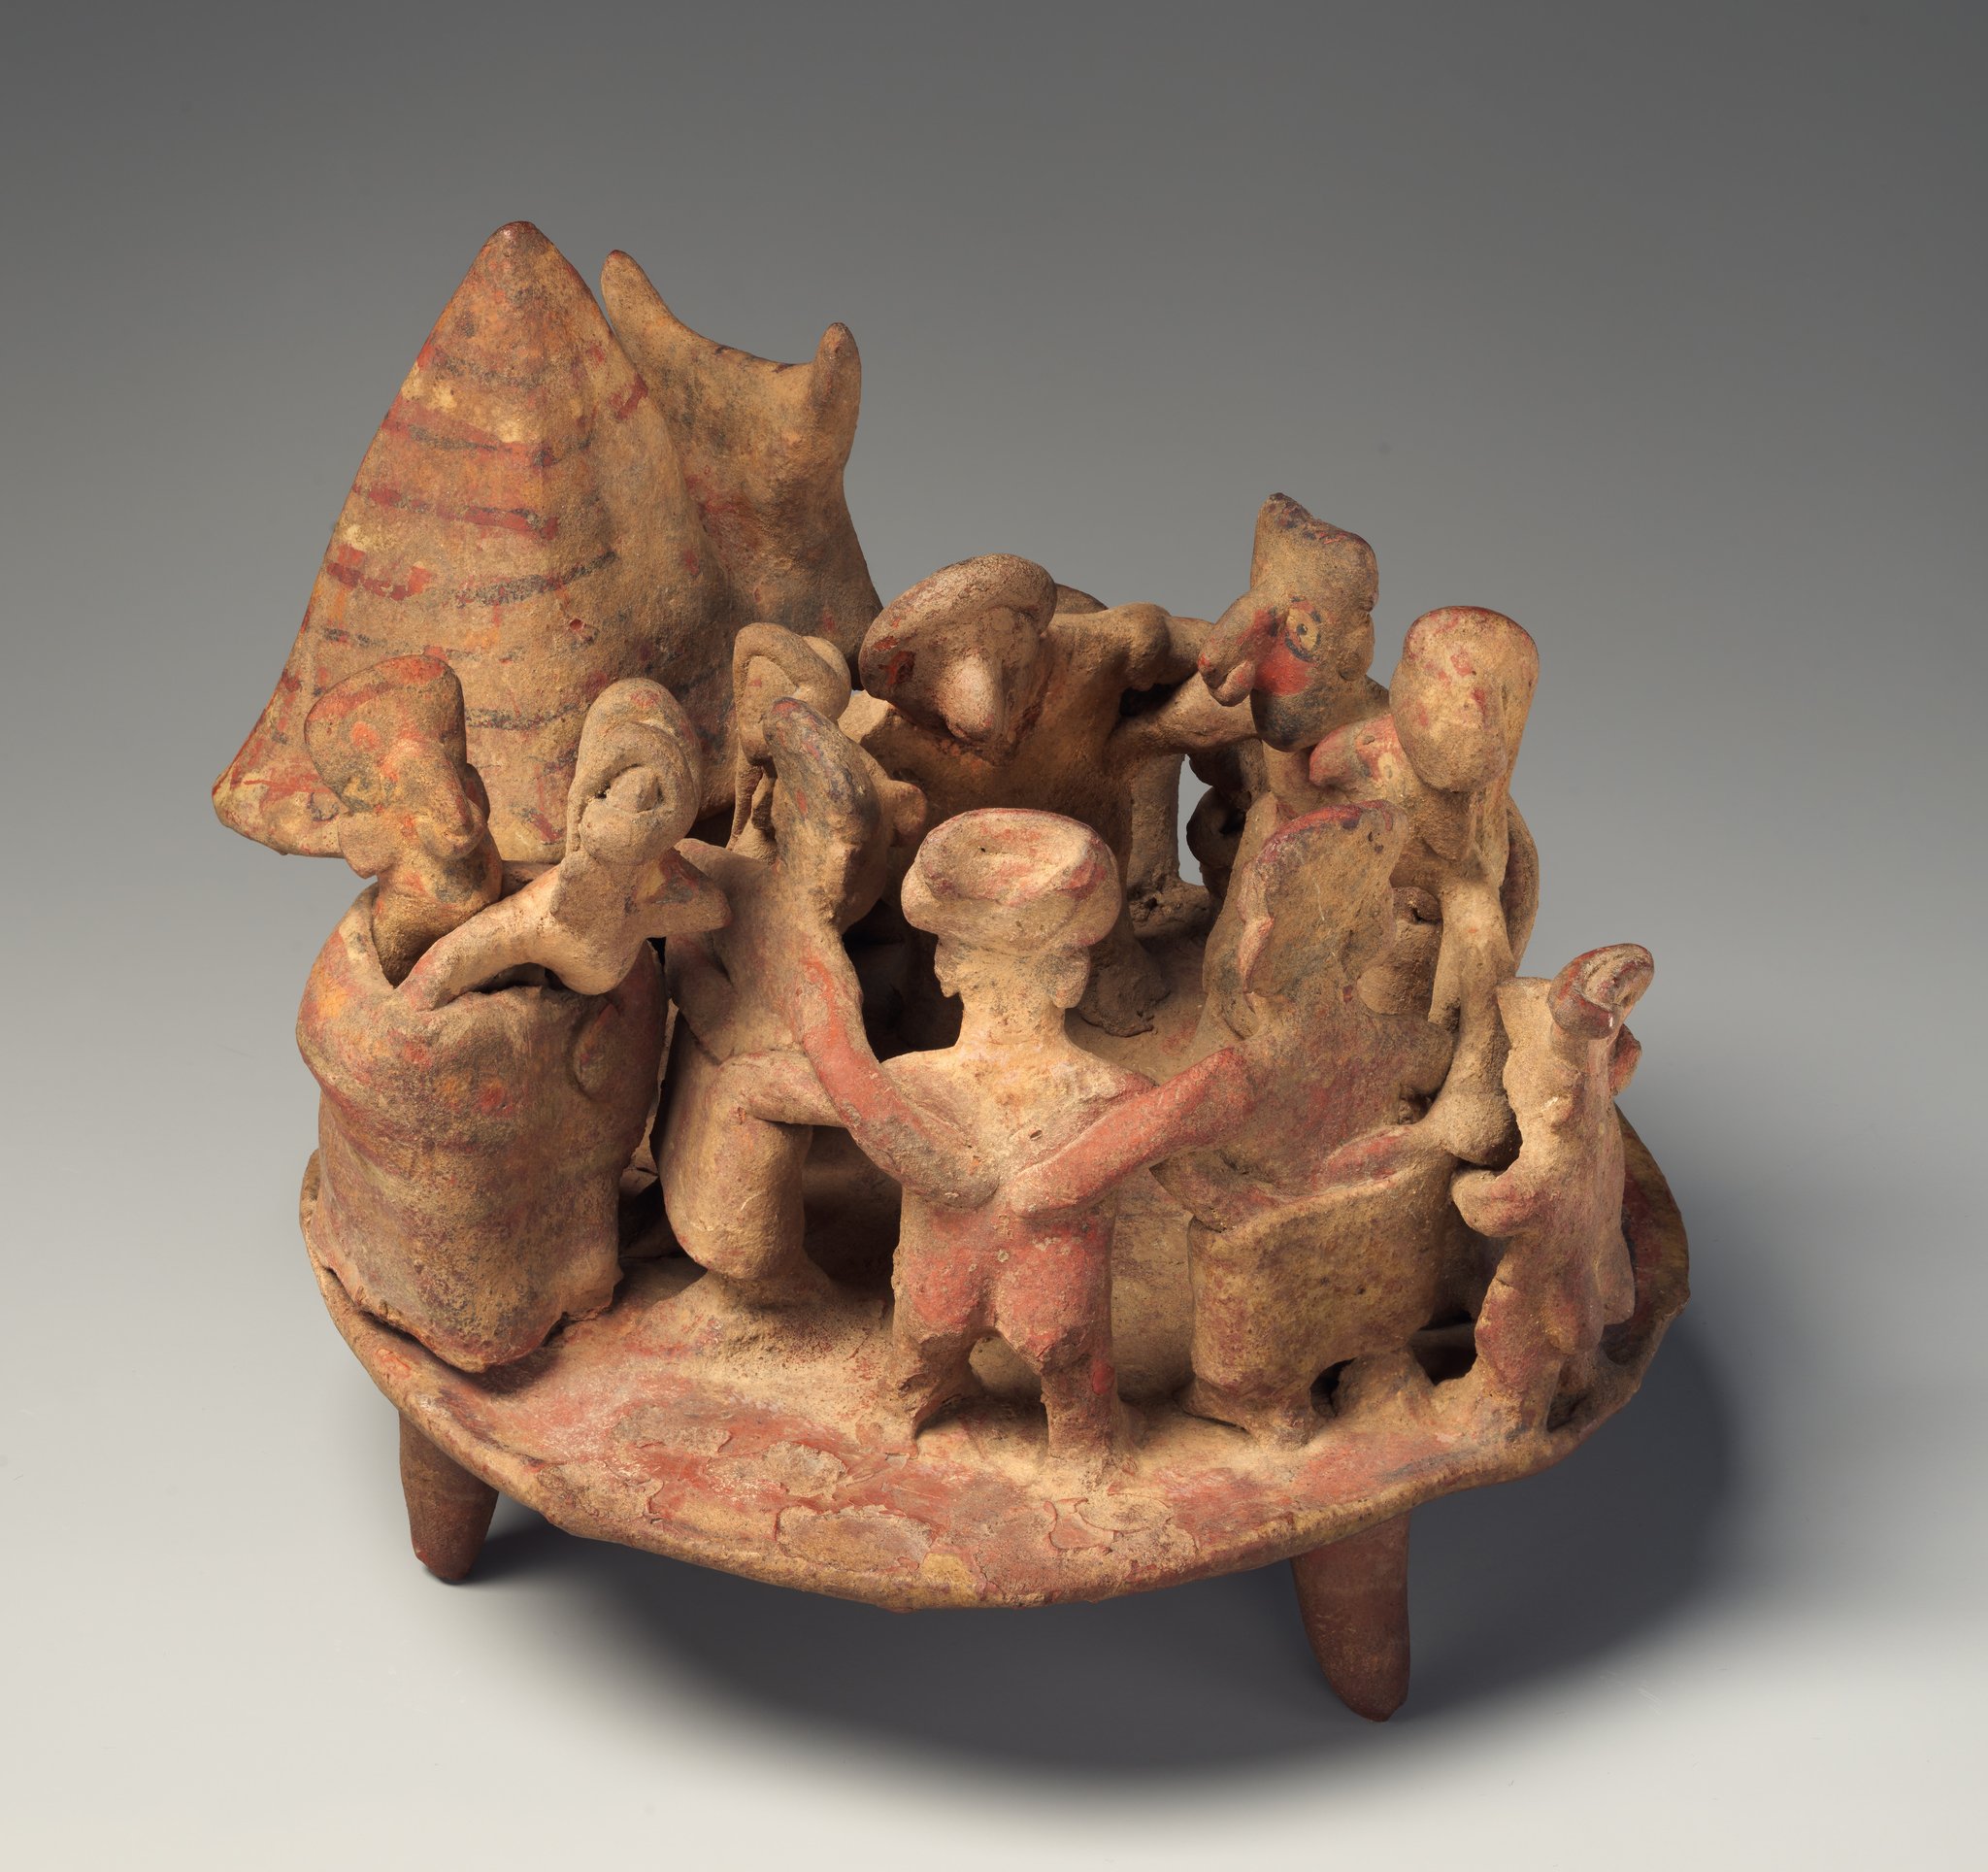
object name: figure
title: Village scene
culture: nayarit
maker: nayarit artist(s)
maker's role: artist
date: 300 BCE-300 CE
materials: ceramic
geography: mexico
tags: villages